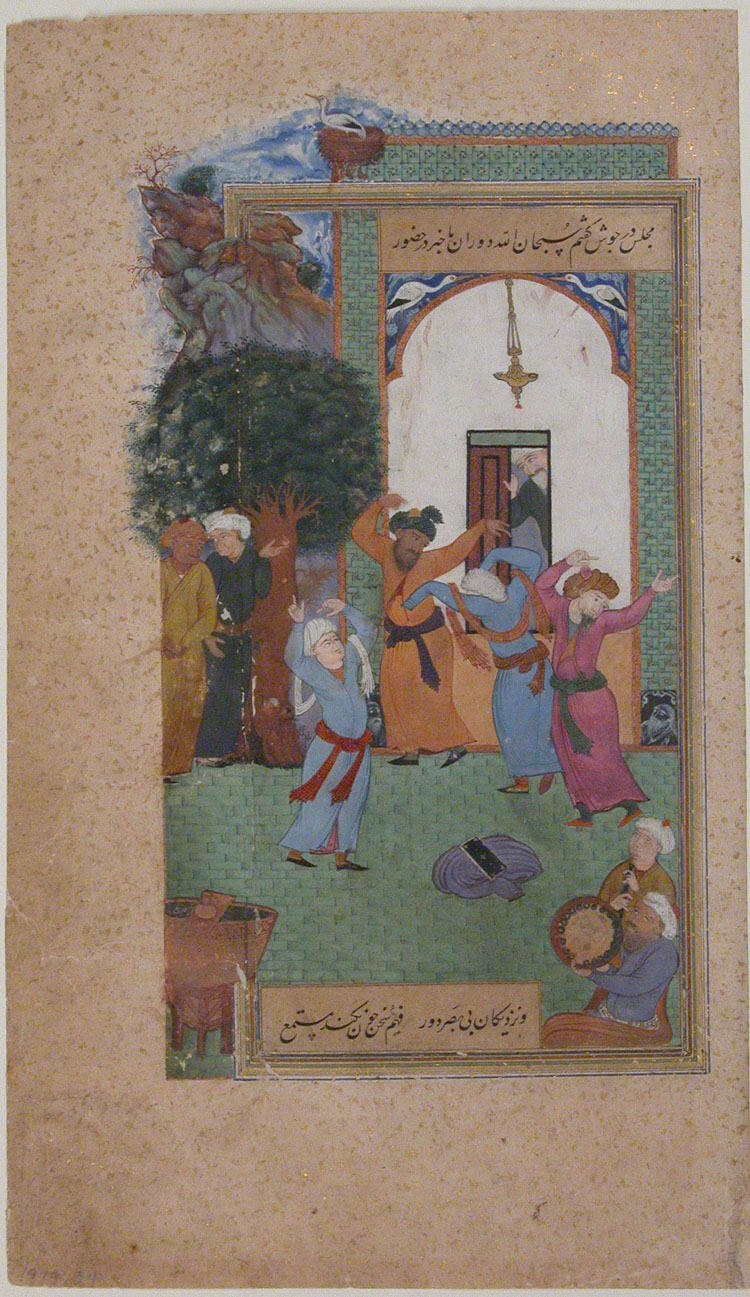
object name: folio from an illustrated manuscript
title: "Dancing Dervishes", Folio from a Gulistan of Sa'di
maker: sa'di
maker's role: author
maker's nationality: iranian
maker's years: 1213-1291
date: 1601-1700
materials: gold, ink, paper, watercolor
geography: iran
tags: men,dancing